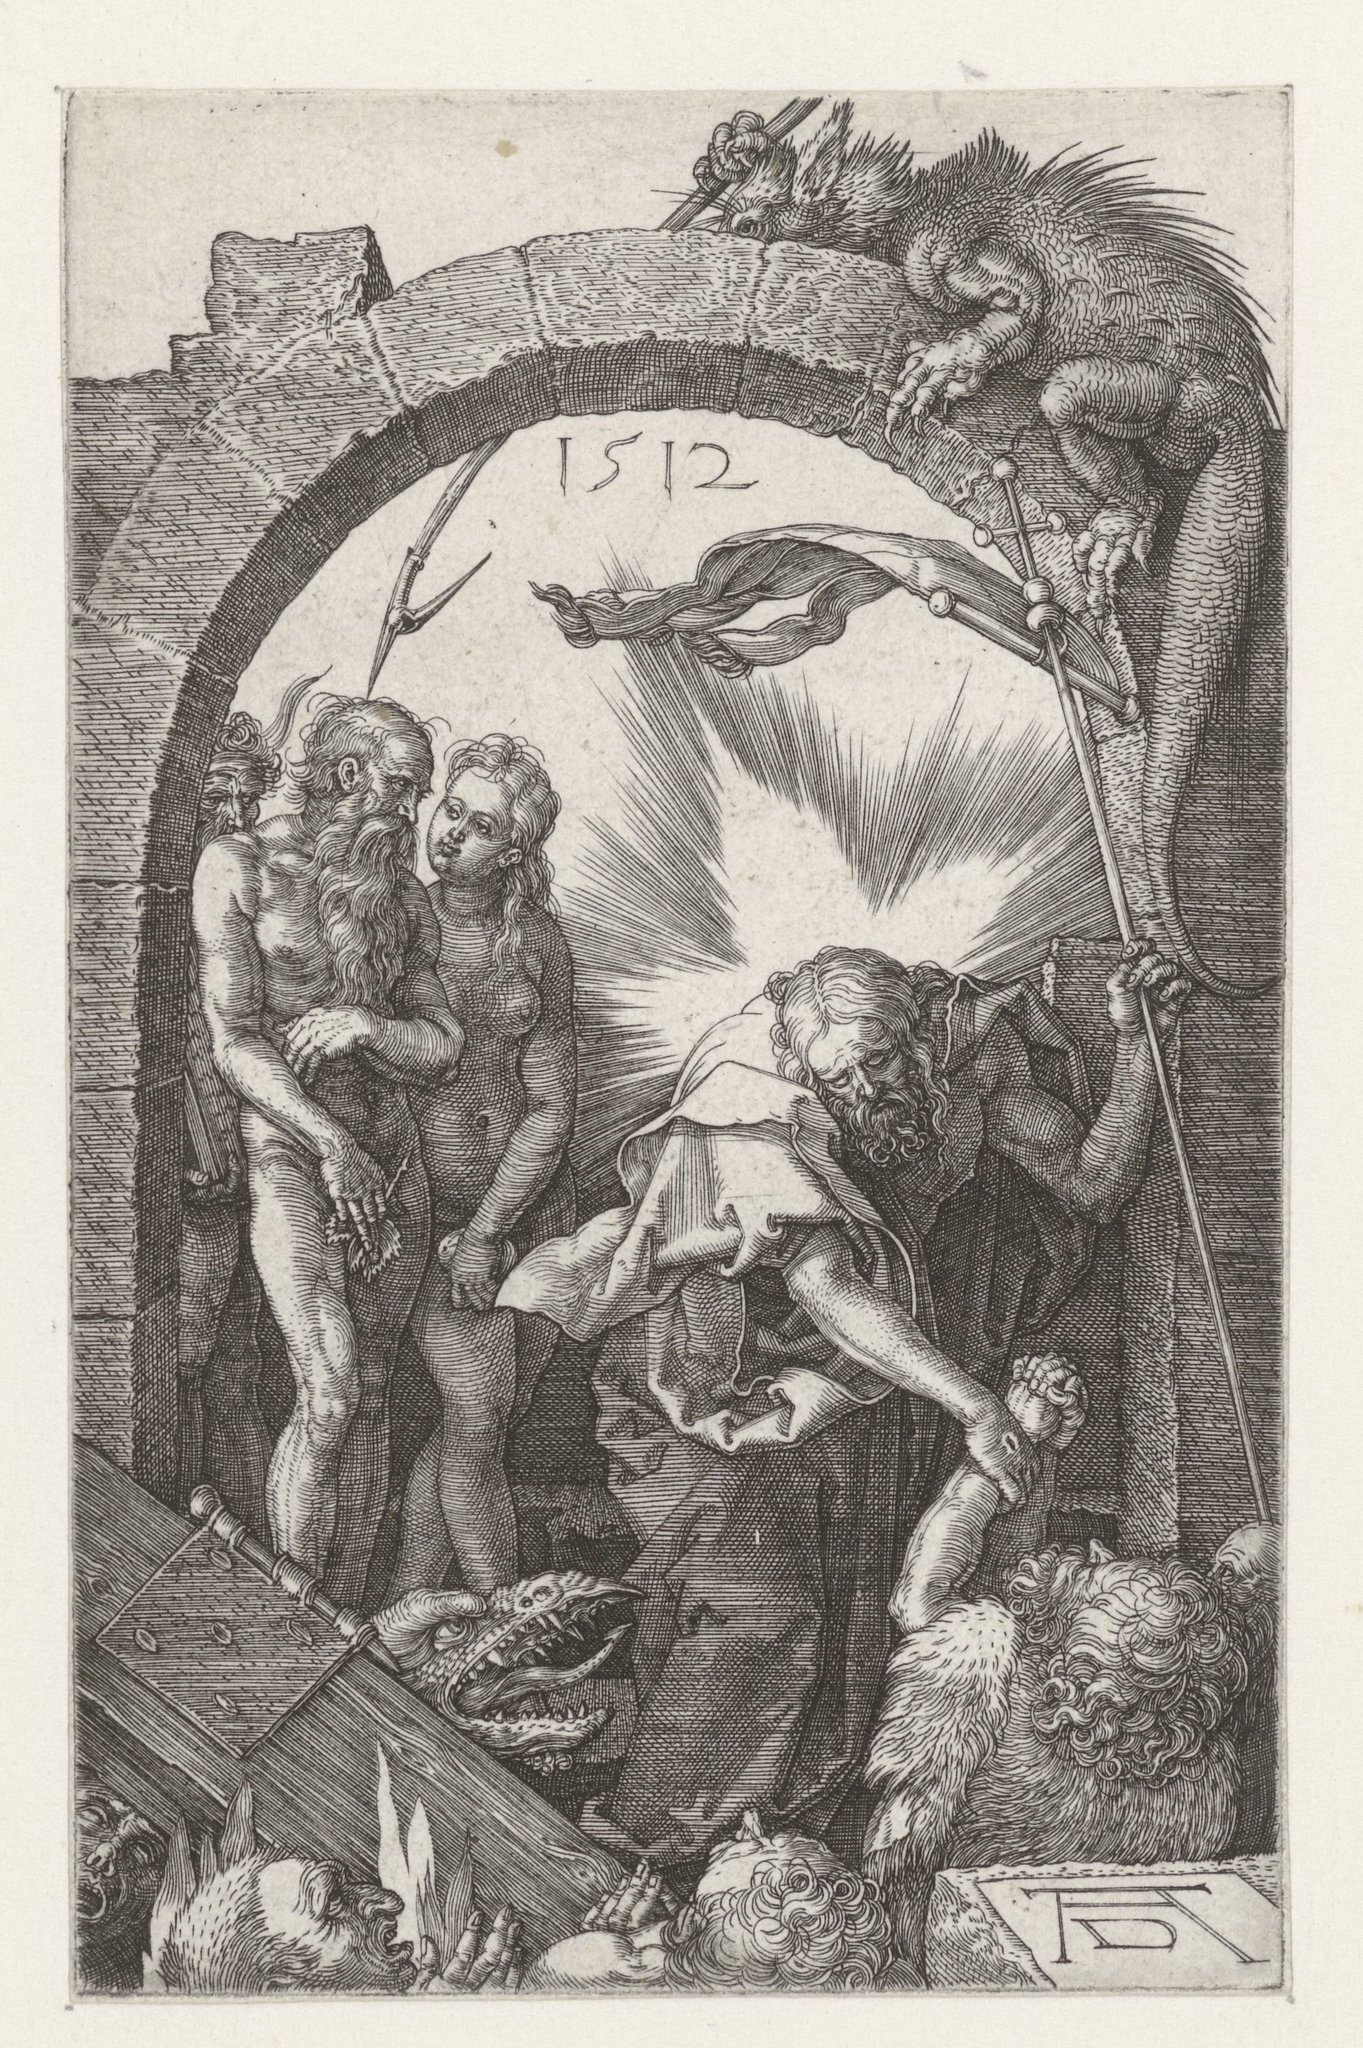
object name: print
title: De afdaling in het voorgeborchte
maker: albrecht dürer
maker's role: draughtsman, painter, print maker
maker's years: 1471-1528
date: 1512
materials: paper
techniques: engraving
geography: nuremberg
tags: christ leaving hell: he liberates patriarchs, prophets, kings and other persons from hell, among them adam, eve, moses, david, and john the baptist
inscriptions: collector's mark: Lugt 2228a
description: Christus, een staf met een vaan in de hand, bevrijdt een groep zielen uit een kerker. Duivels proberen dit tevergeefs te verhinderen. Adam en Eva staan al buiten de hellepoort. Deze prent is onderdeel van een serie van 16 prenten met scènes uit het Lijdensverhaal.